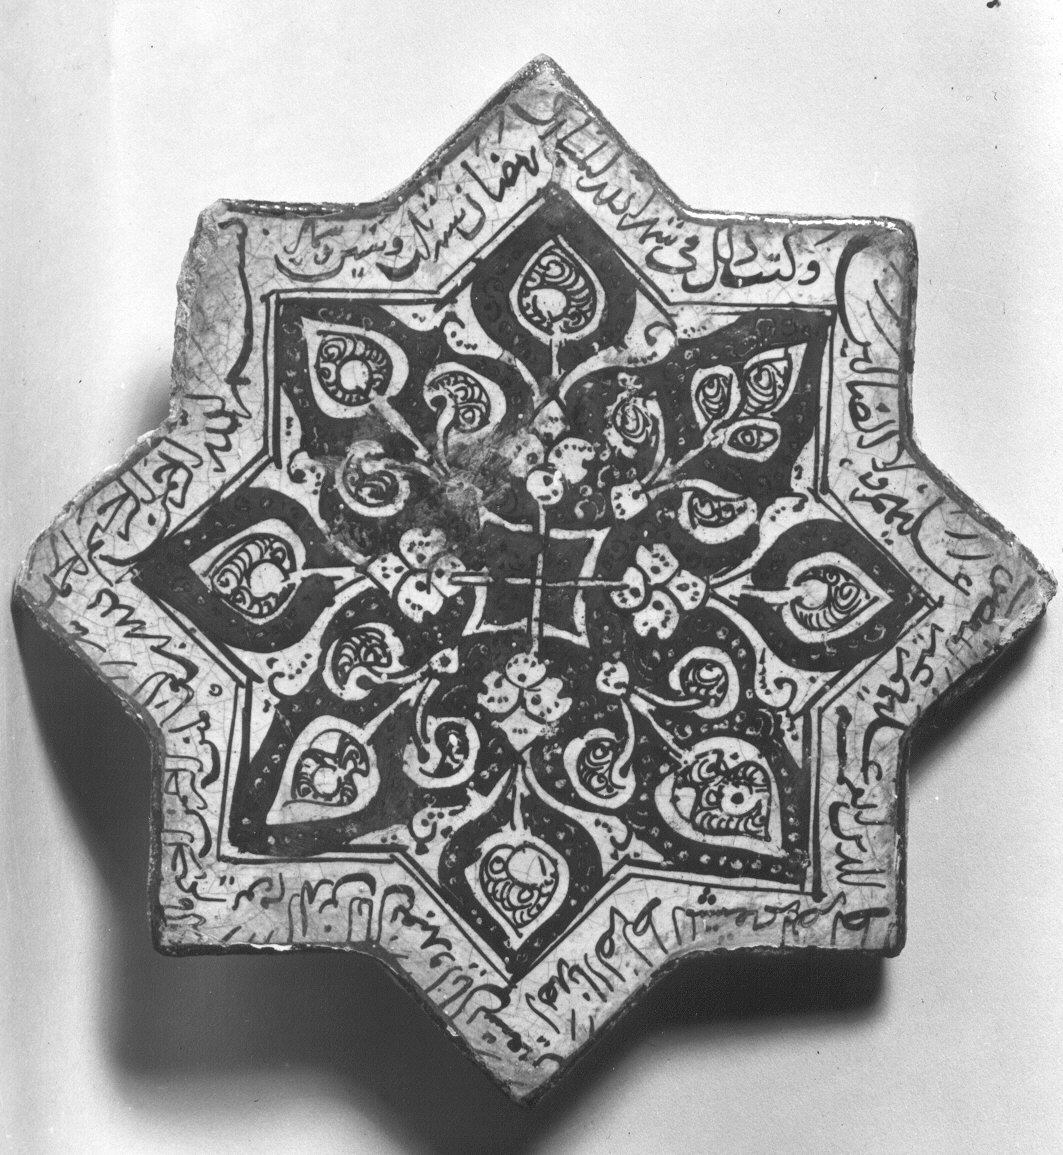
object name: tile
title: Star-Shaped Tile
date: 1260-1270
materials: glaze, stonepaste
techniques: luster painting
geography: iran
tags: leaves